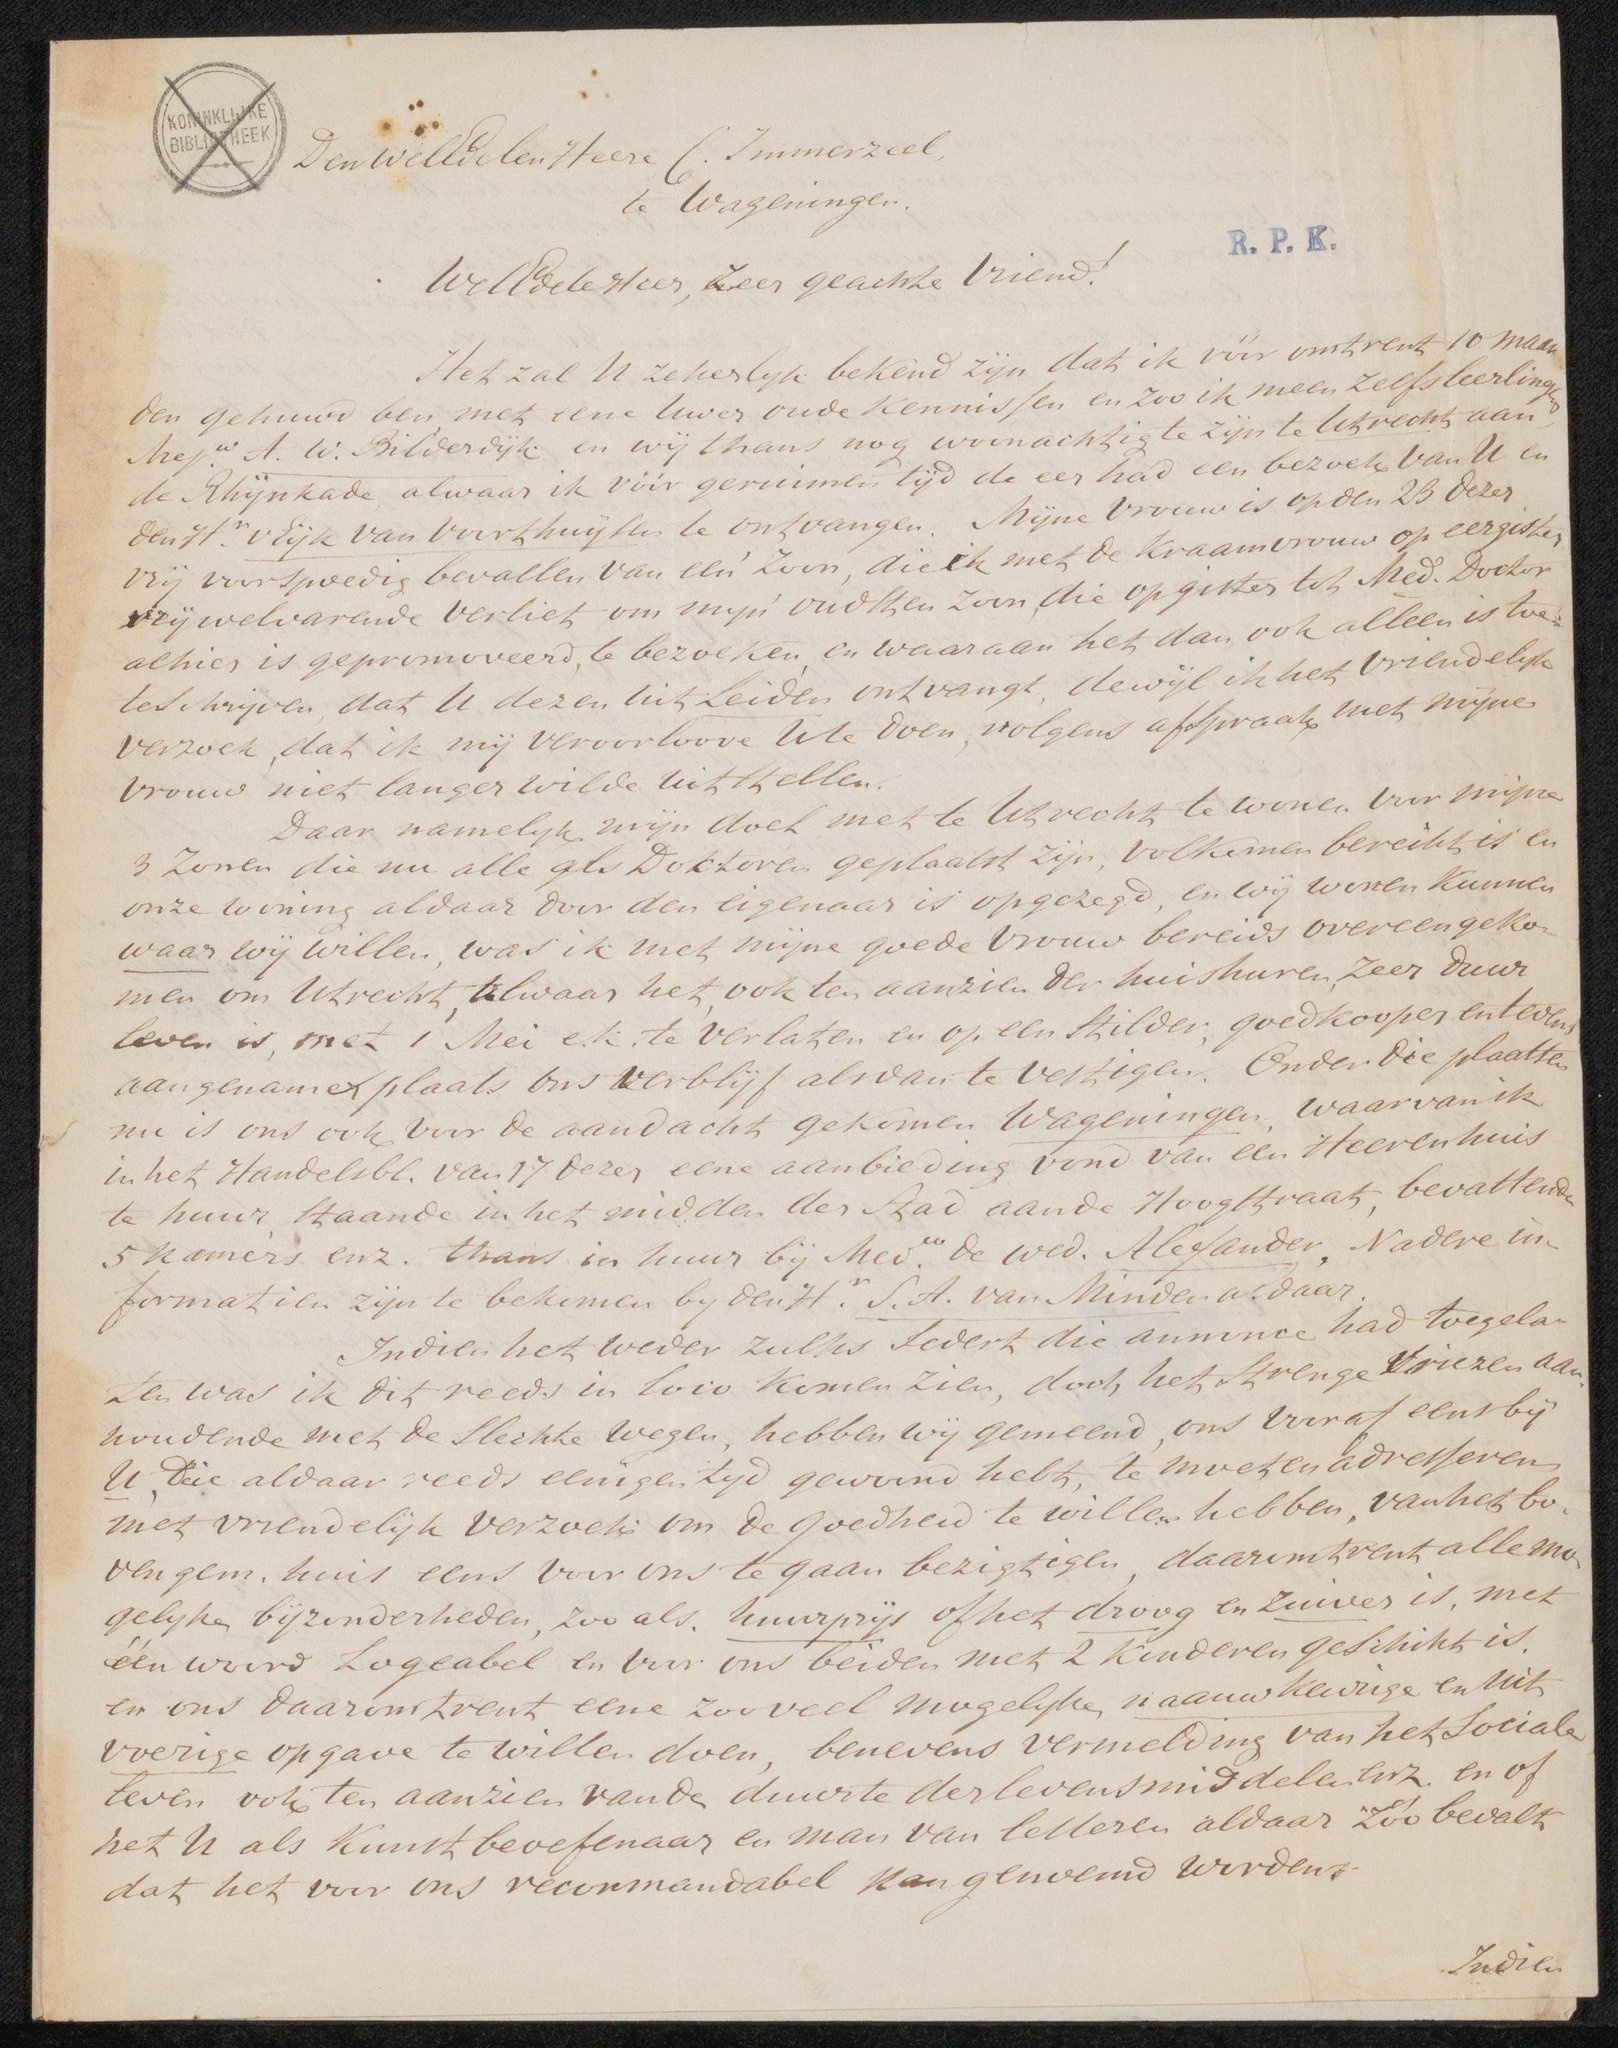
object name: letter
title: Brief aan Christiaan Immerzeel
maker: gillis de meijer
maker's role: draughtsman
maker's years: 1790-1867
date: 1855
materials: ink, paper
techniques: pen, writing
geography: leiden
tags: amsterdam, painter, draughtsman, christiaan immerzeel, family life, utrecht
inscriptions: collector's mark: Lugt 2233, collector's mark: ‘KONINKLIJKE/ BIBLIOTHEEK’